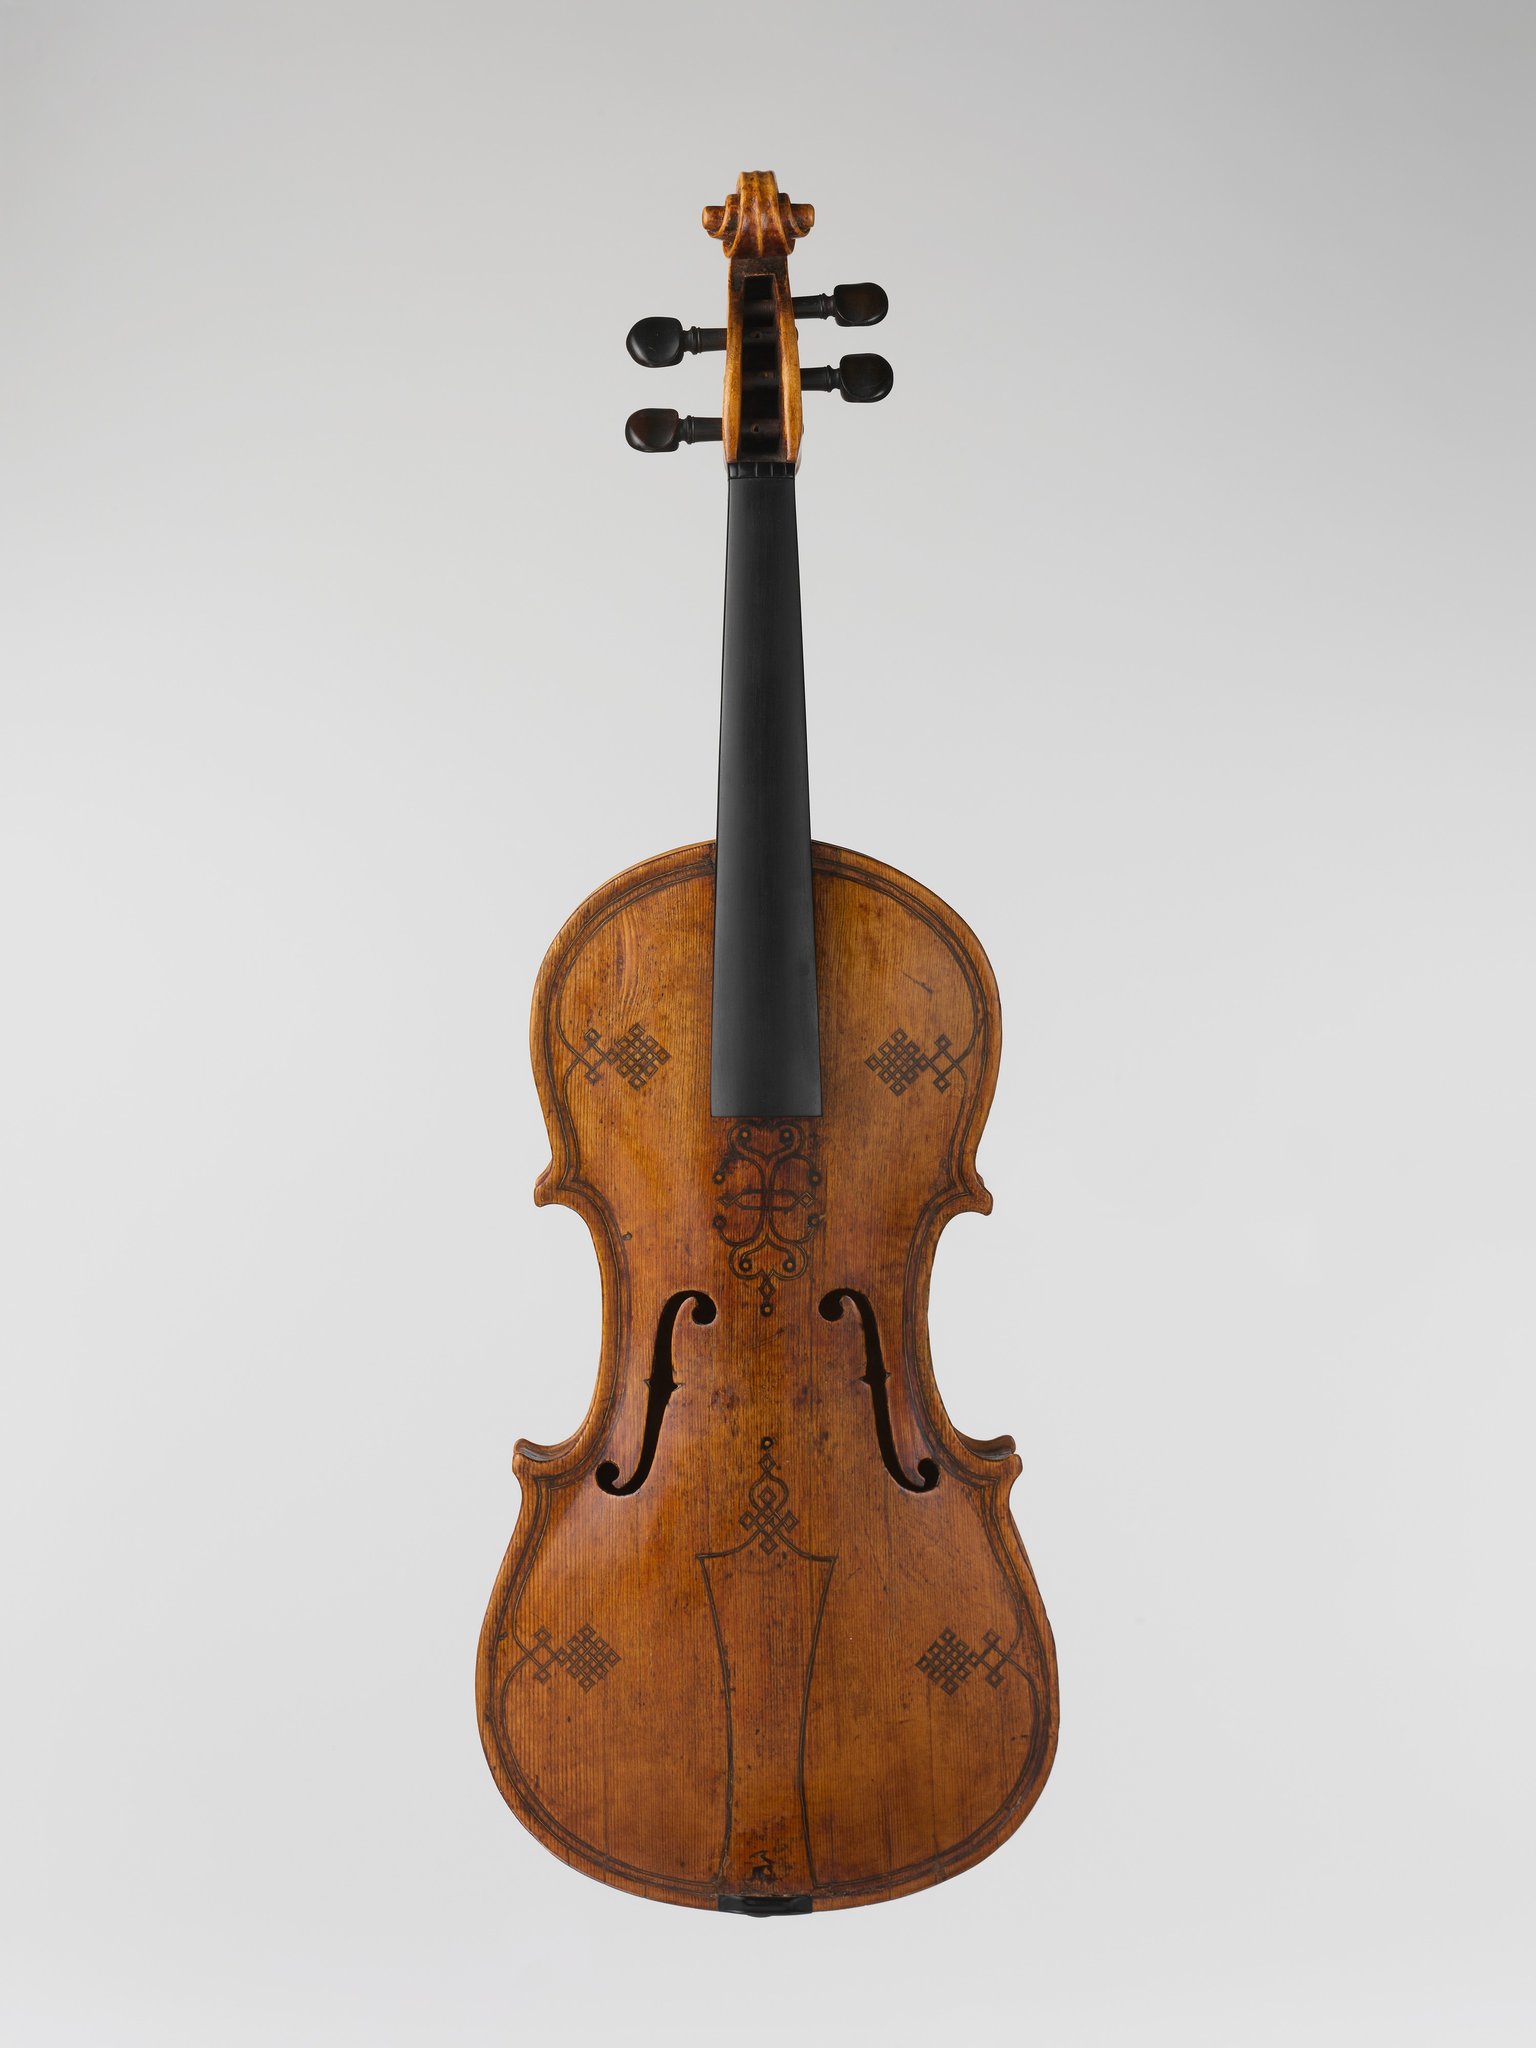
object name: violin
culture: british or german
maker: Anonymous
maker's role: maker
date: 1625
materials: wood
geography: england